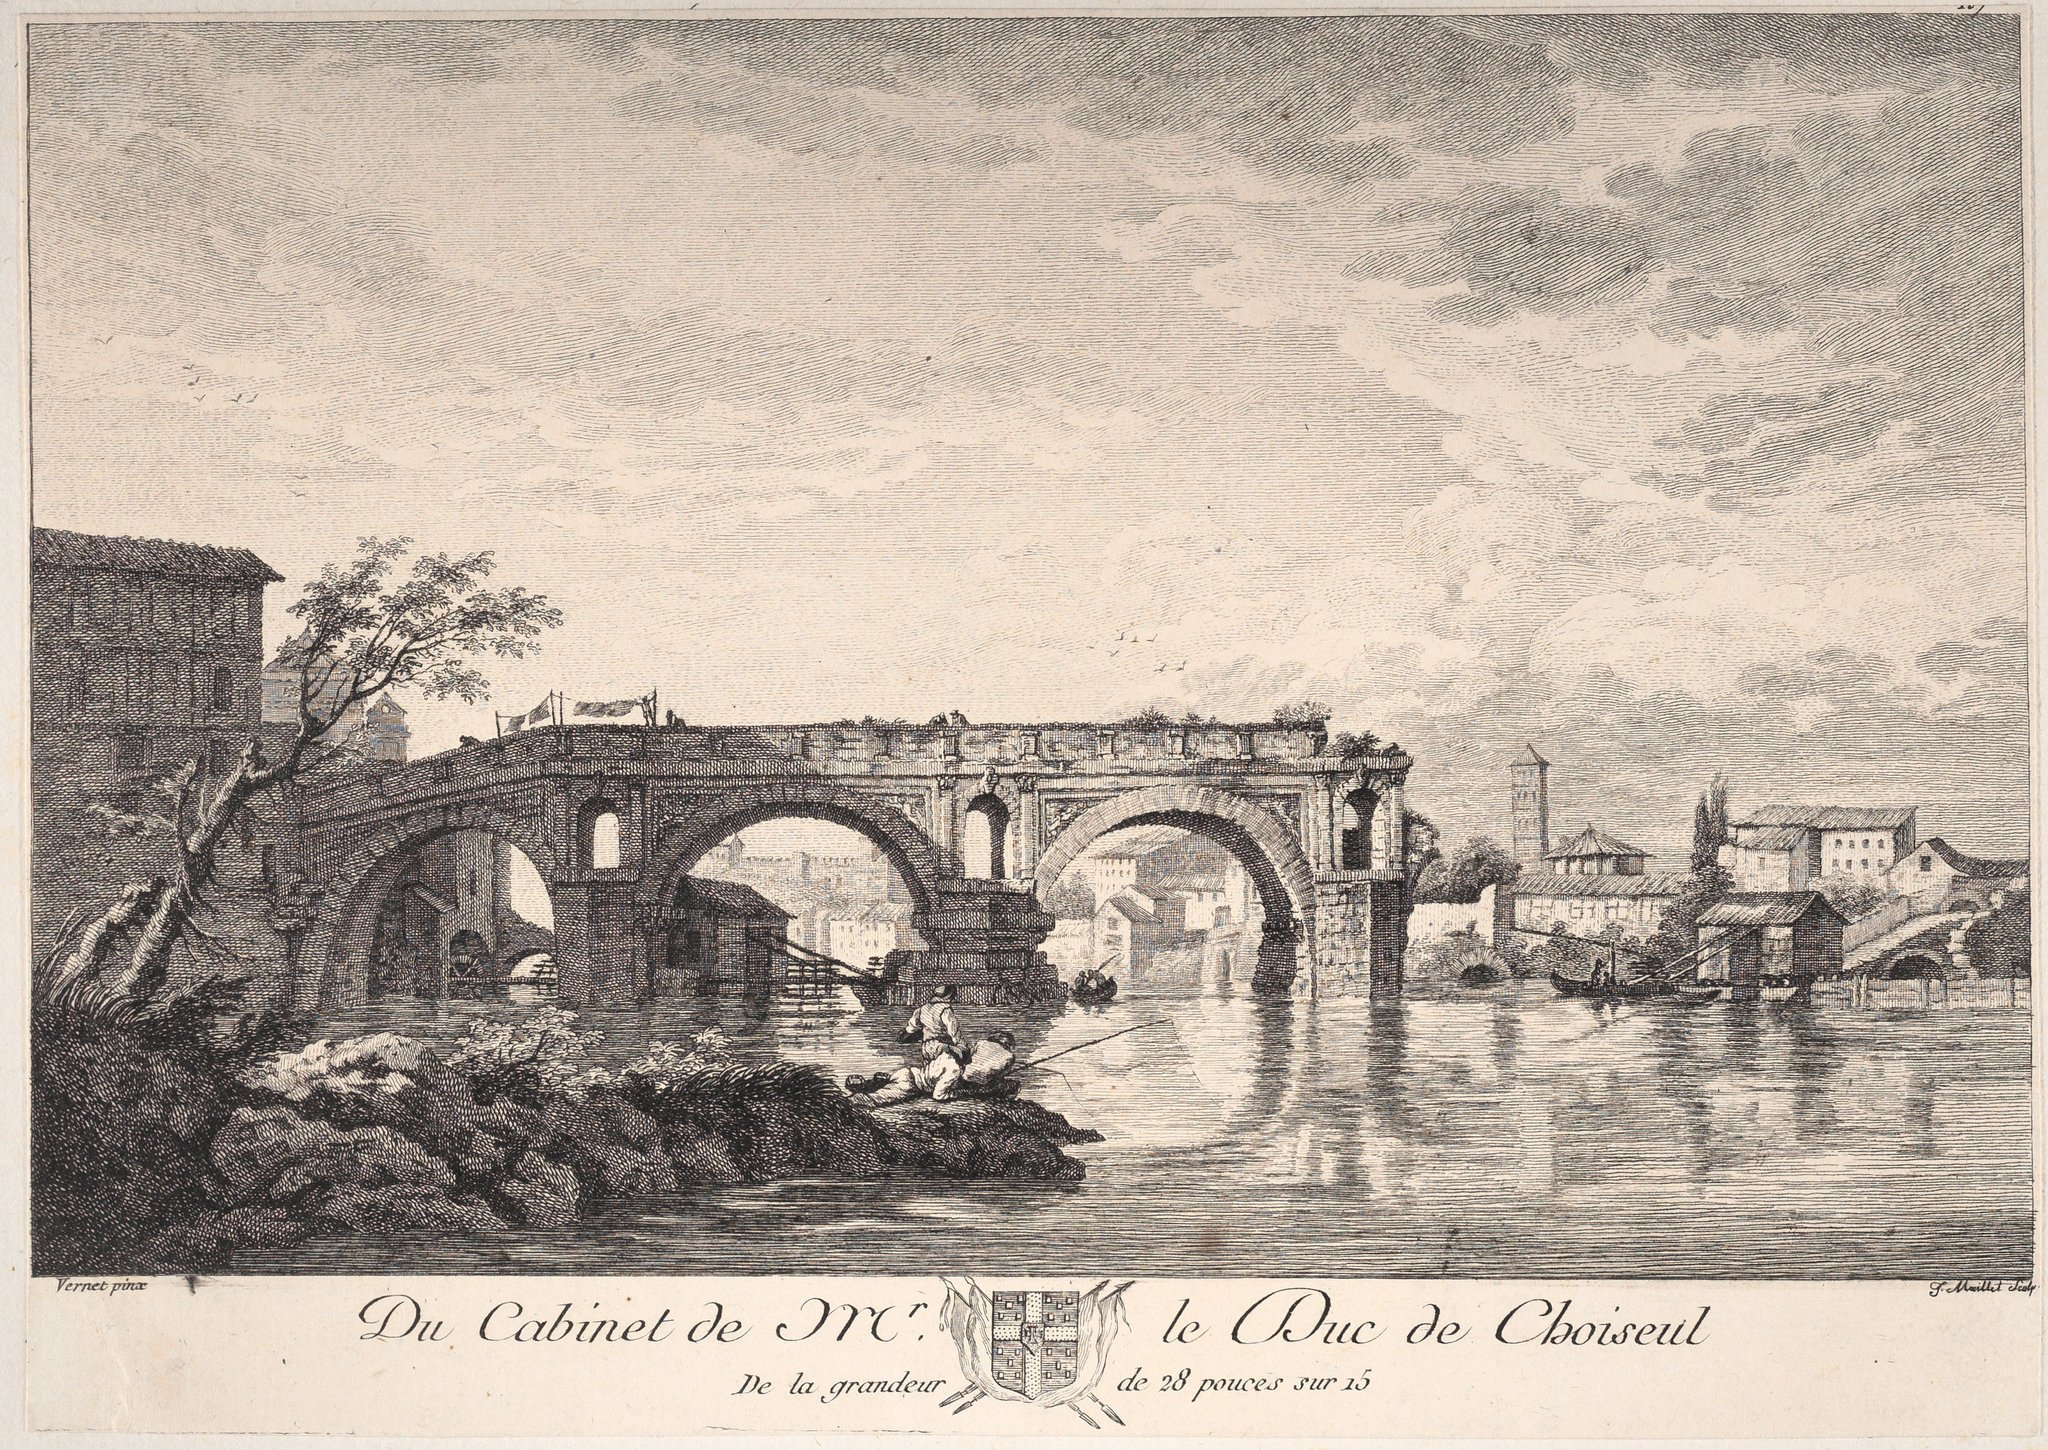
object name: print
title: Bridge in Rome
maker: joseph vernet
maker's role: artist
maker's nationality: french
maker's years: 1714-1789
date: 1770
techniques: engraving